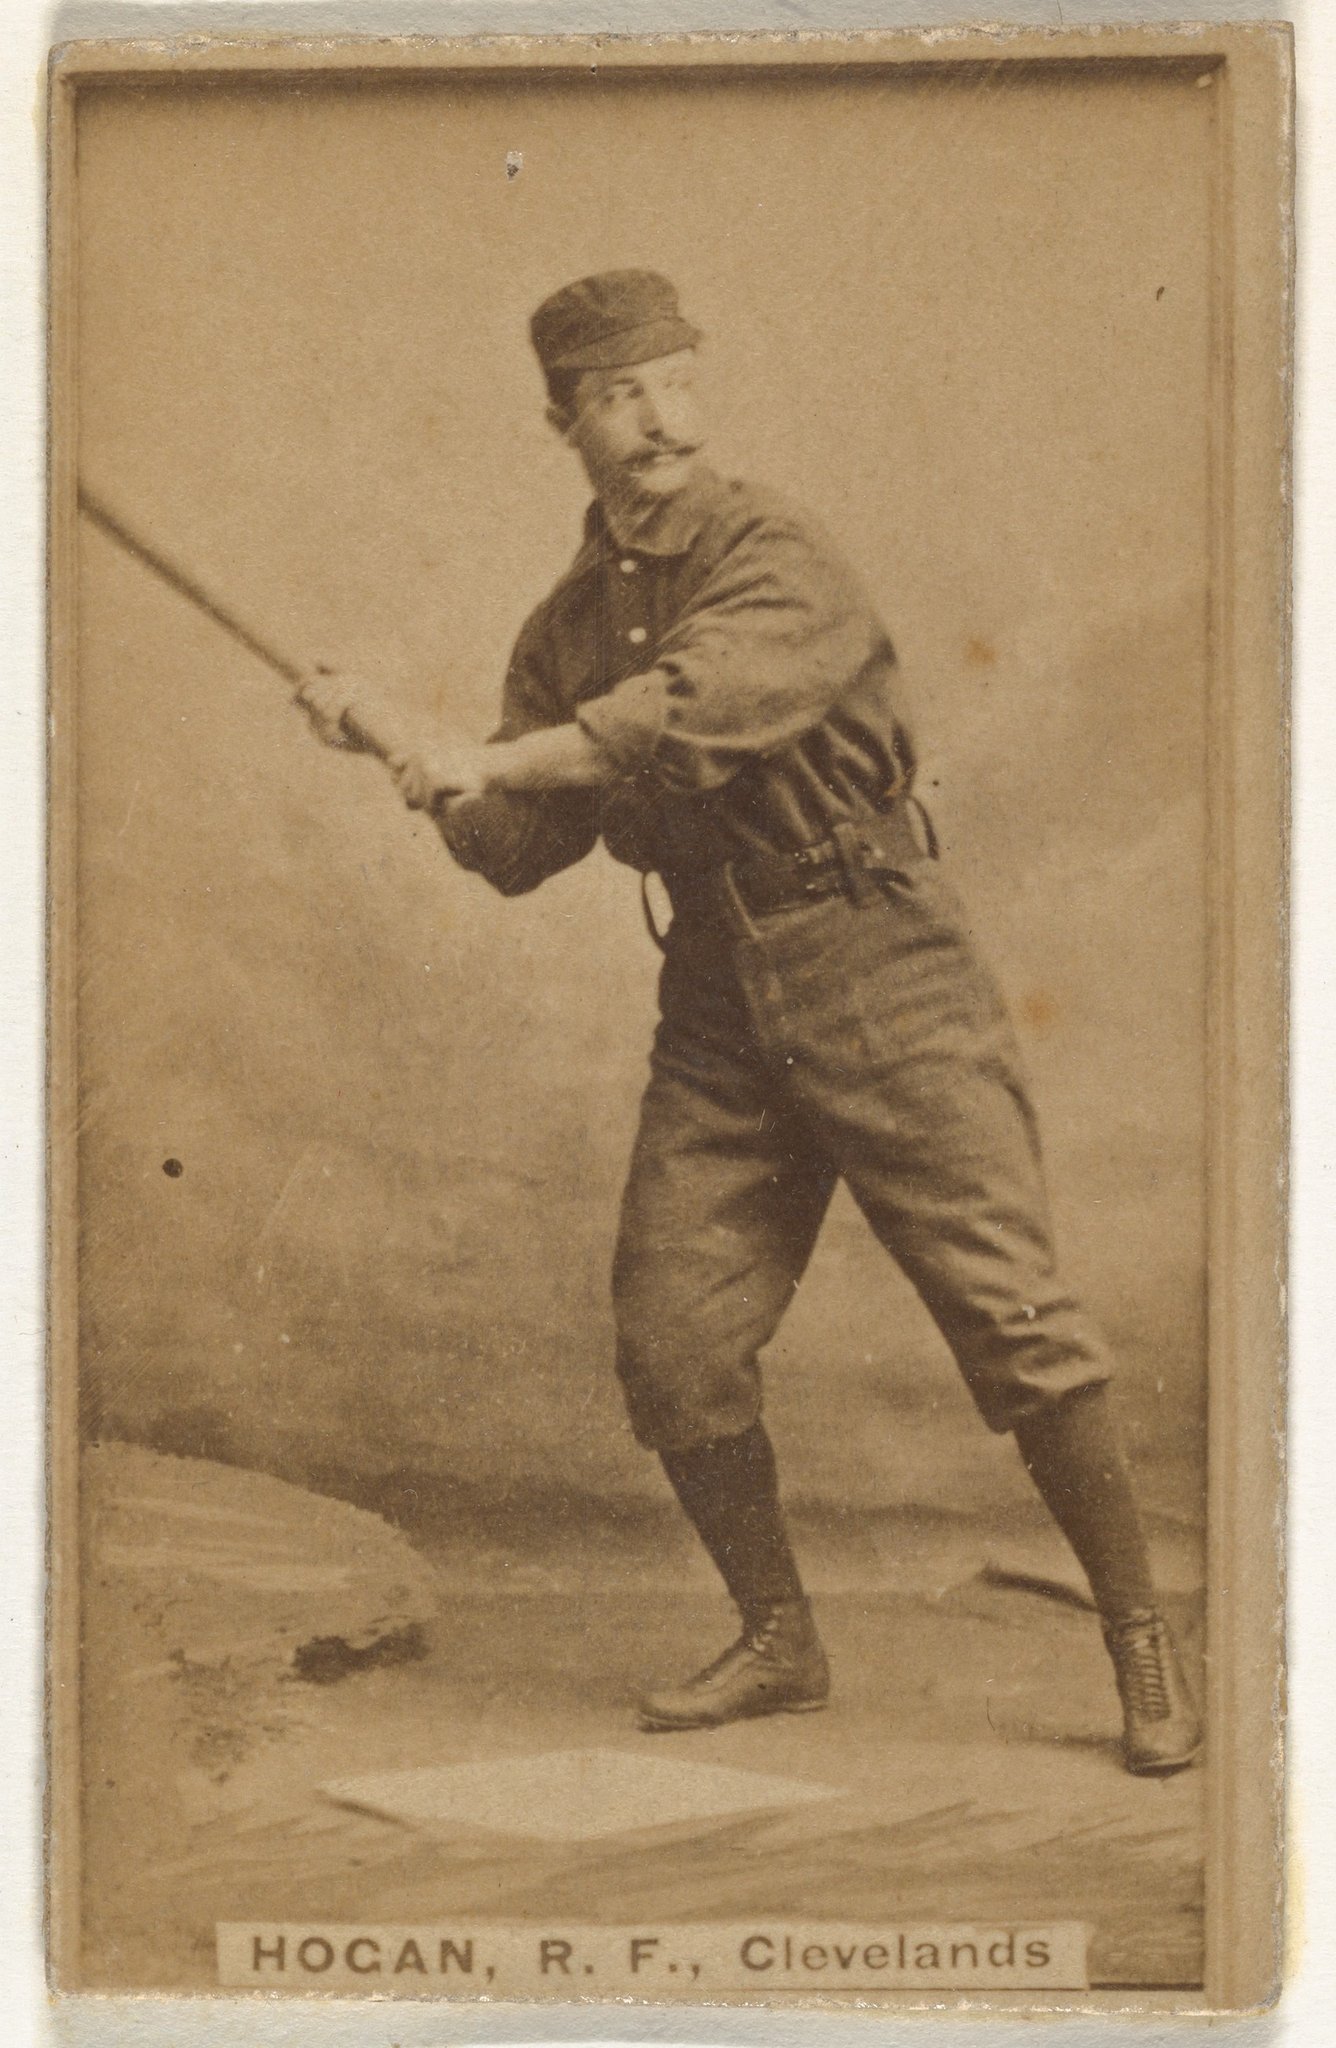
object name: baseball card, photograph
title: Mortimer Edward Hogan, Right Field, Cleveland, from the Old Judge series (N172) for Old Judge Cigarettes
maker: goodwin & company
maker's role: publisher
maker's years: 1850-1950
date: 1887-1890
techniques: albumen silver print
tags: men,portraits,baseball,athletes